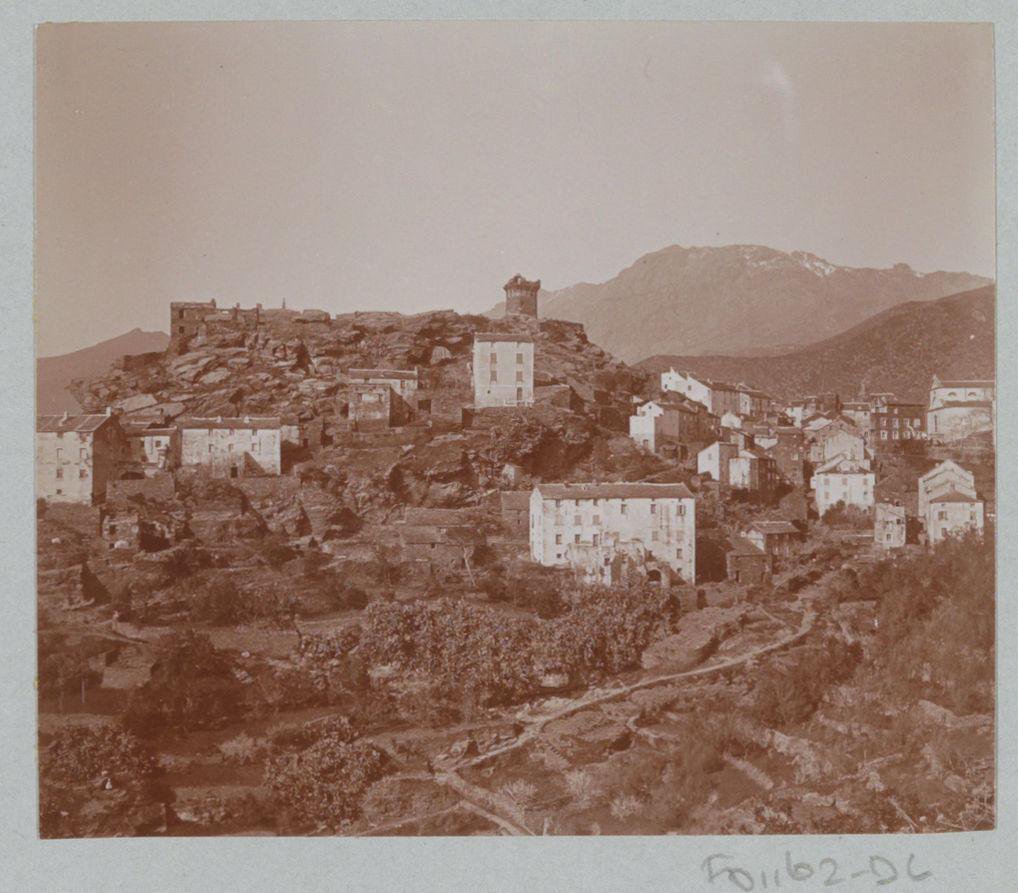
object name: photograph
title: Gezicht op een dorp met een Genuese toren op Corsica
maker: Anonymous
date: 1905-1910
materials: paper, photographic support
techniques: gelatin silver print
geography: corsica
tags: prospect of village, silhouette of village, landscape with tower or castle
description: Onderdeel van Fotoalbum van een Franse amateurfotograaf met bezienswaardigheden in Frankrijk, Zwitserland en Italië.